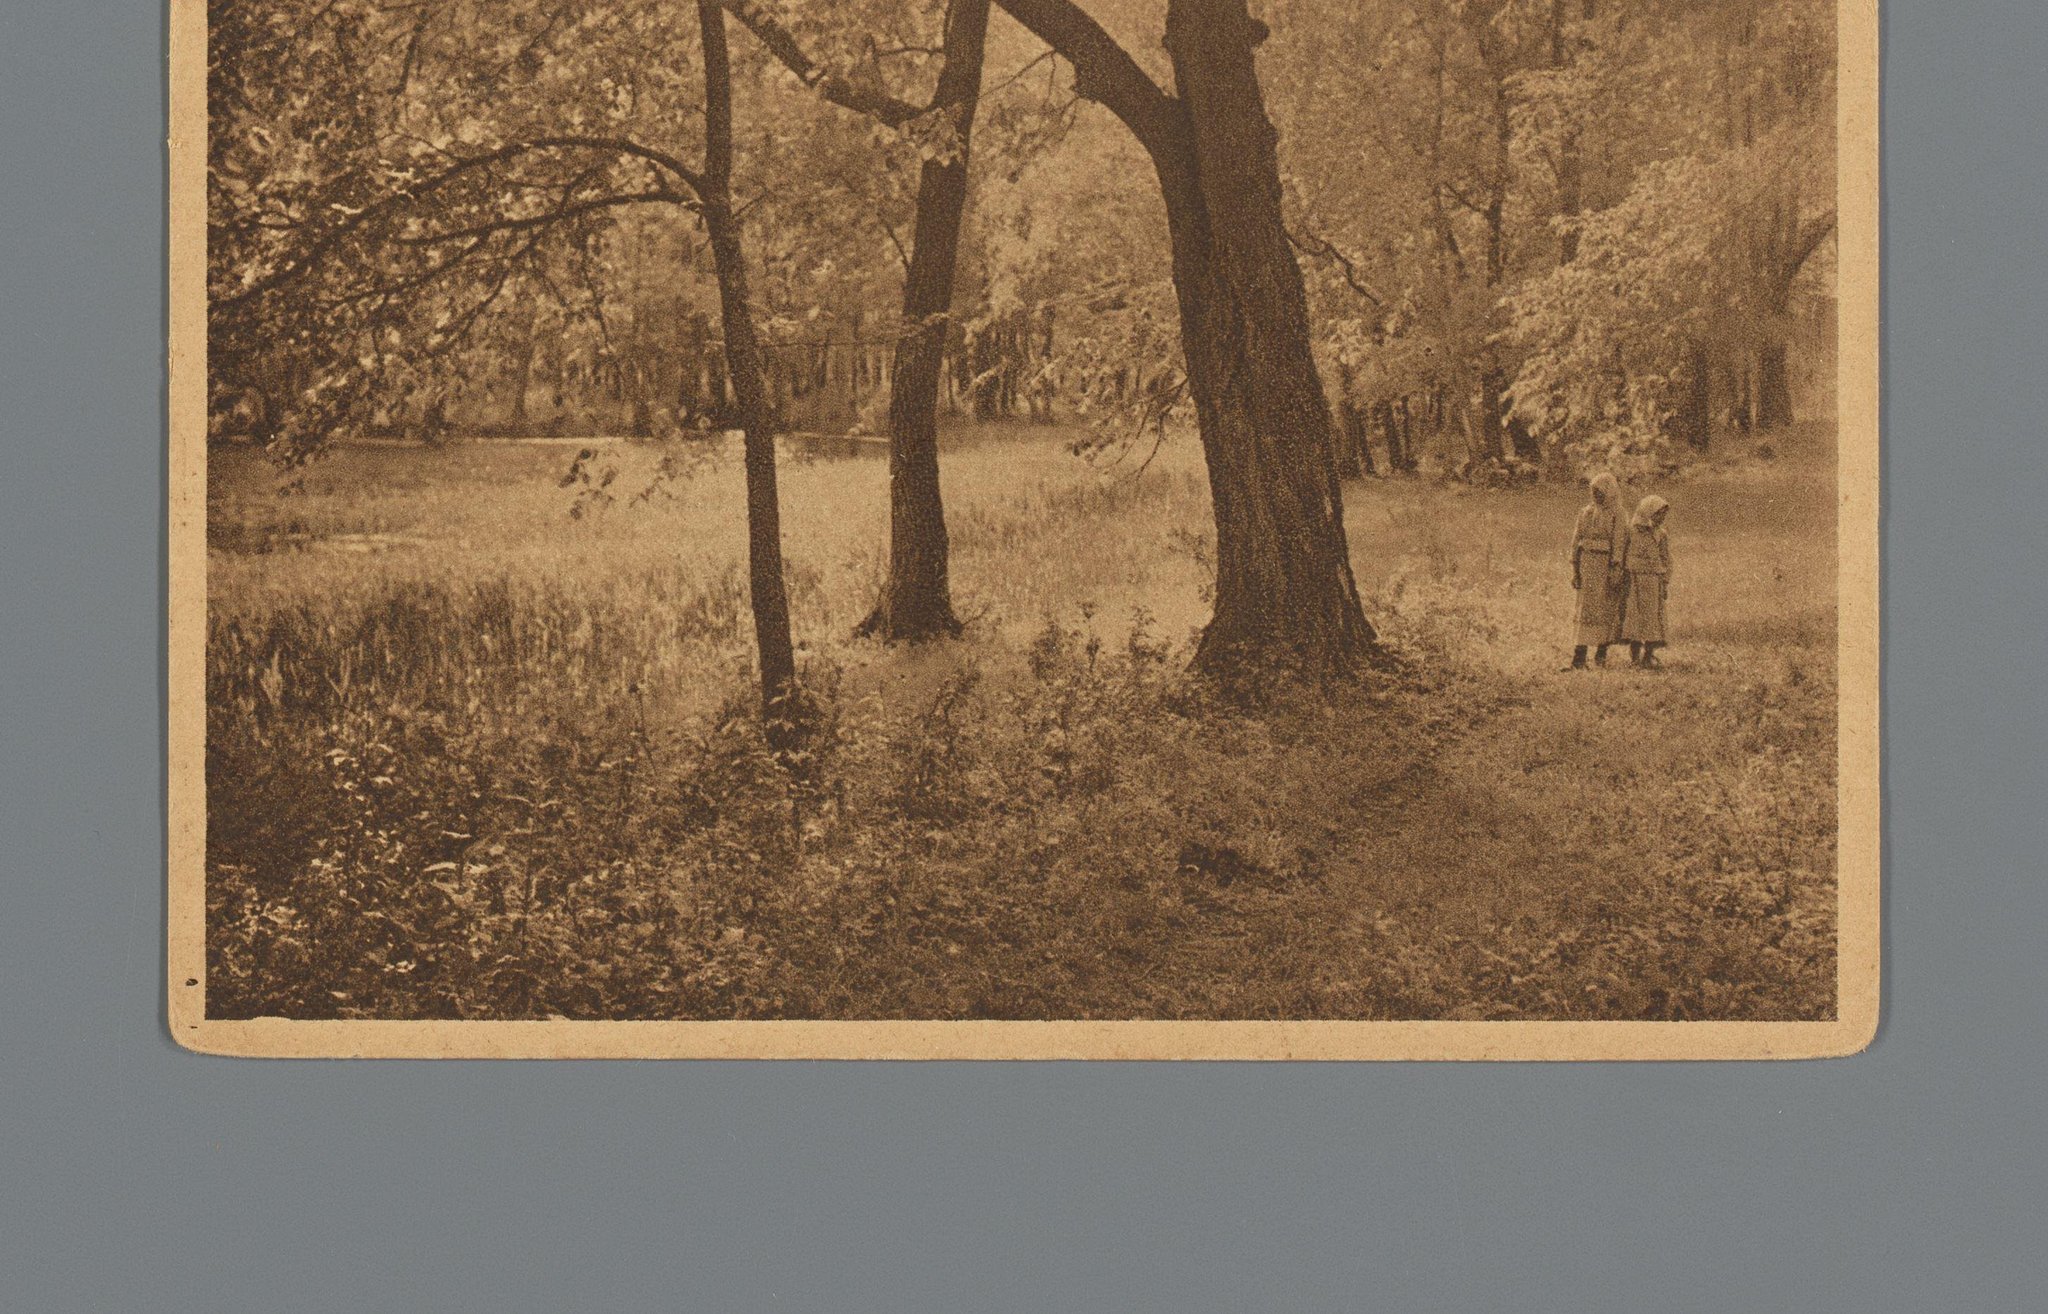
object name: photomechanical print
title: Bosgezicht met twee meisjes, advertentie voor ververij en stomerij 'De Regenboog', Tilburg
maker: Anonymous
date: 1915-1939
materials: paper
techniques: rotogravure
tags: forest, wood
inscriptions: number: ‘€3,00’, inscription: ‘"DE REGENBOOG"/ TILBURG/ STOOMEN - VERVEN/ van/ winterkleeding,/ sportkleeding,/ avondtoletten,/ alle soorten pelswerken./ Stoppage-Plisseerinrichting/ keurig werk! billijke prijzen!/ filialen te amsterdam:/ Vijzelstraat 45 - Tel. 45910/ P. C. Hoofdstr. 99 - Tel. 20500/ Van Woustr. 19 - Tel. 21808/ Linnaeustr. 56 - Tel. 51950/ K.-F. 8. Nr. 29/ "Velka"’